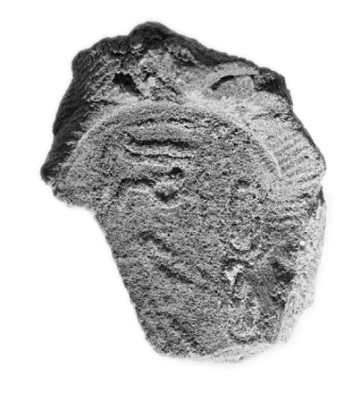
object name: sealing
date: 1981-1640 BCE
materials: mud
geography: egypt